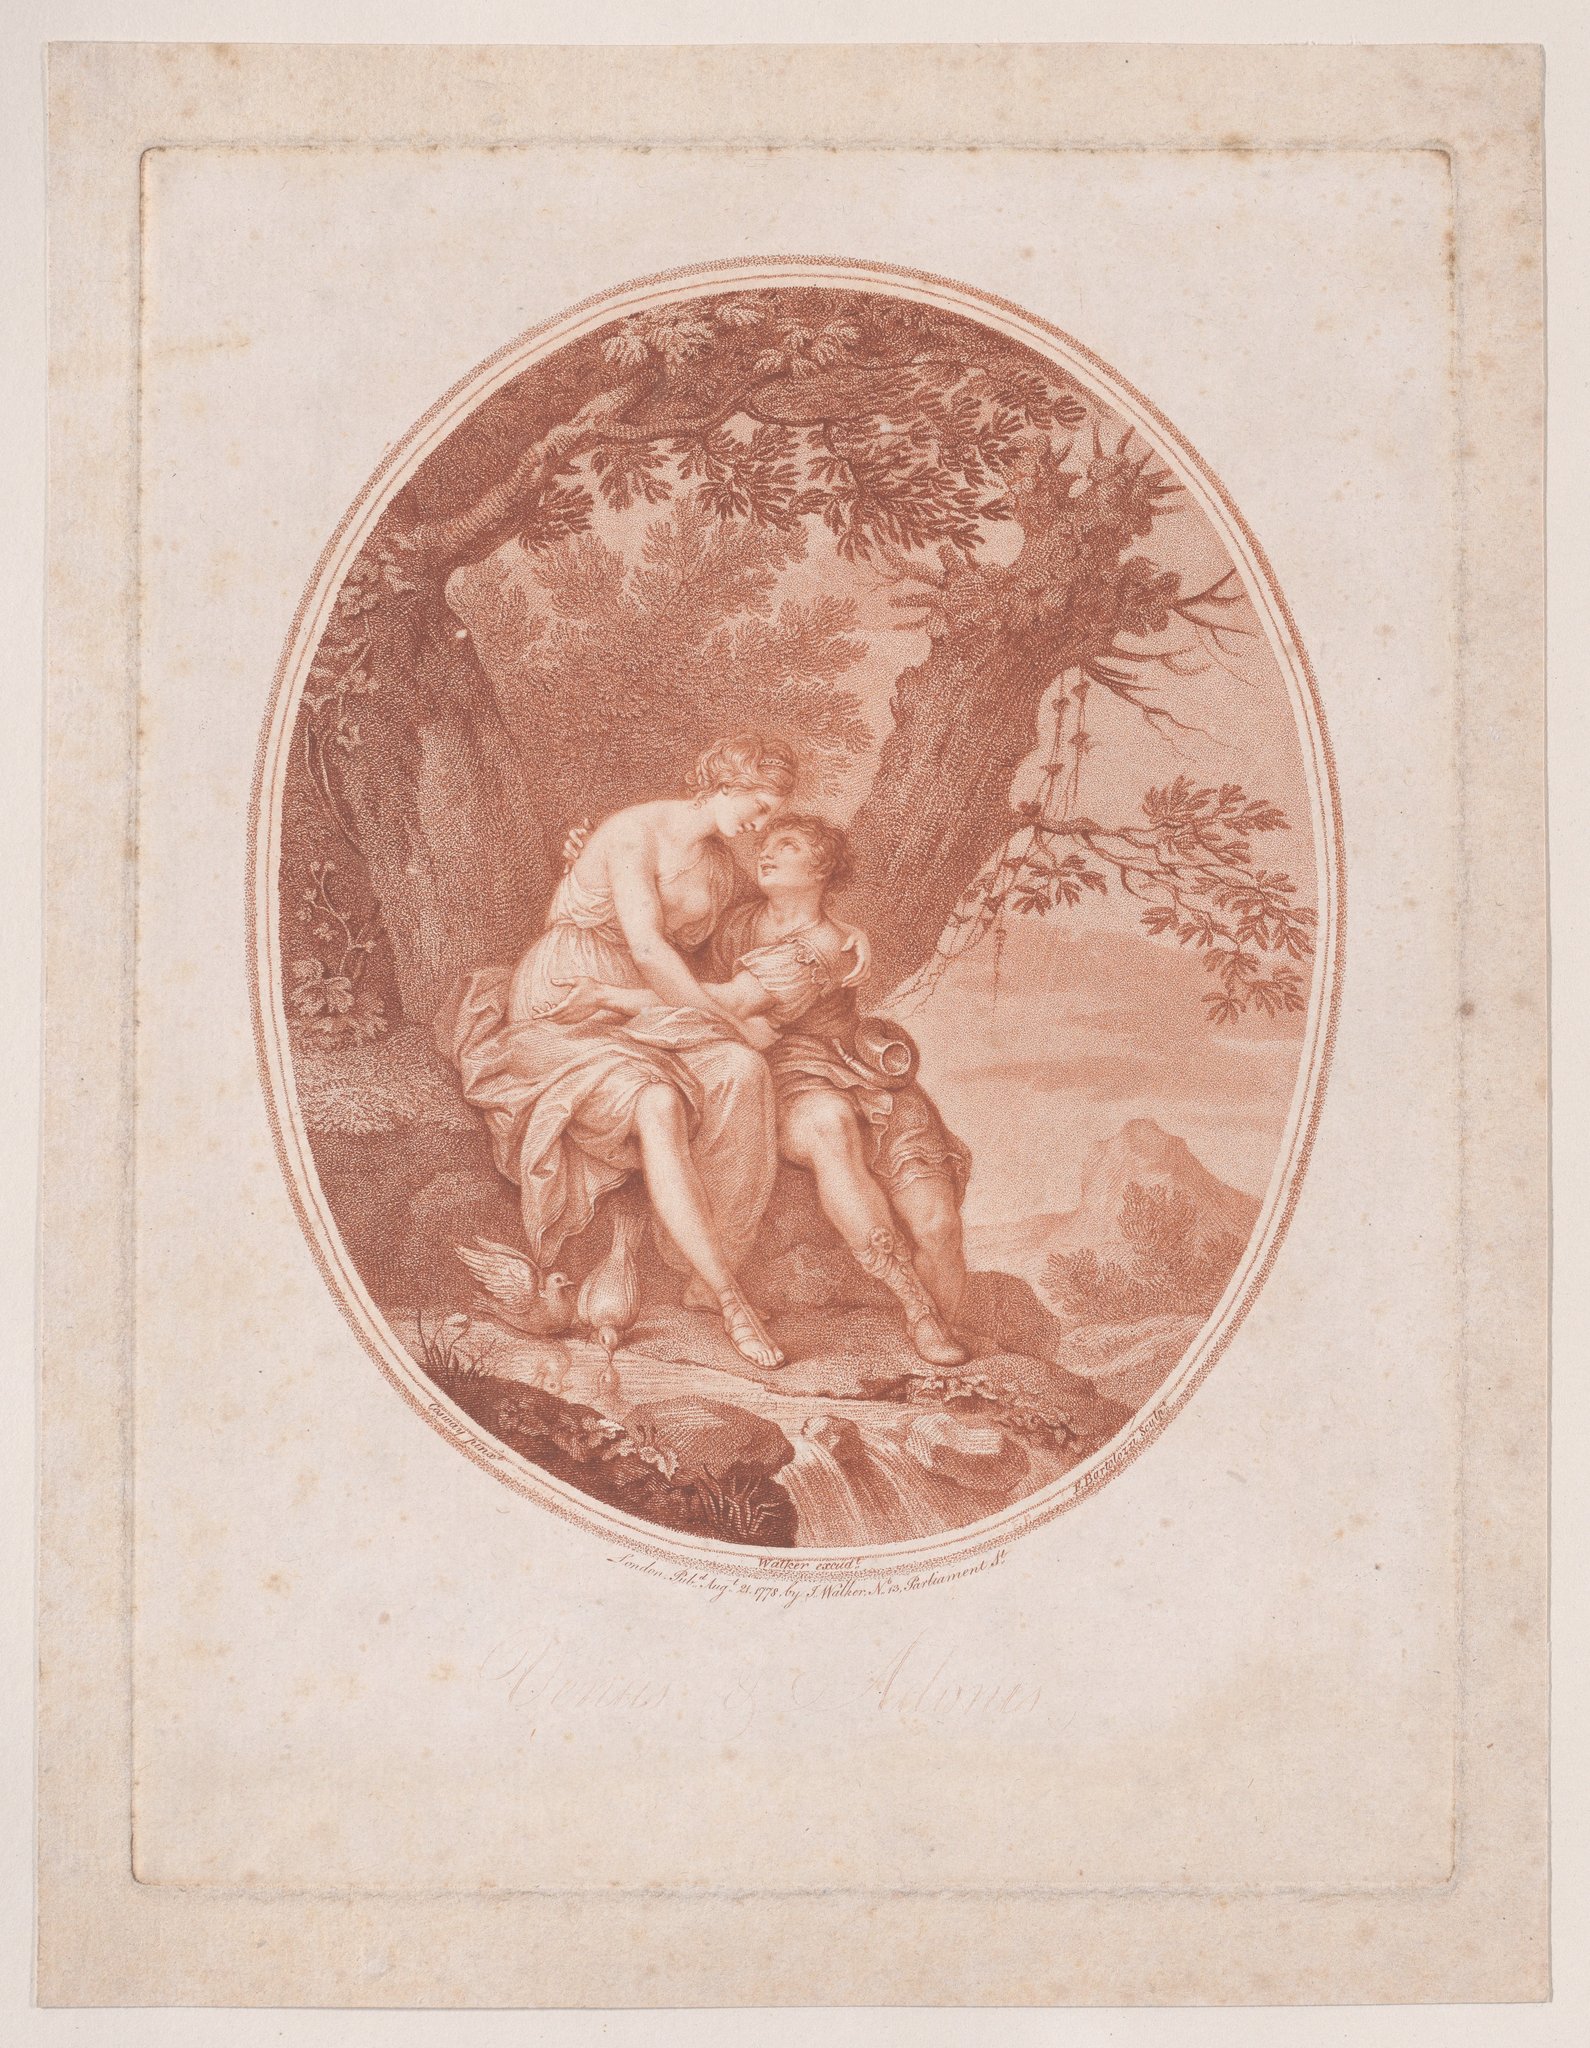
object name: print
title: Venus and Adonis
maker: francesco bartolozzi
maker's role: artist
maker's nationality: italian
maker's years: 1728-1815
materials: ink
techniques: etching, printing, engraving